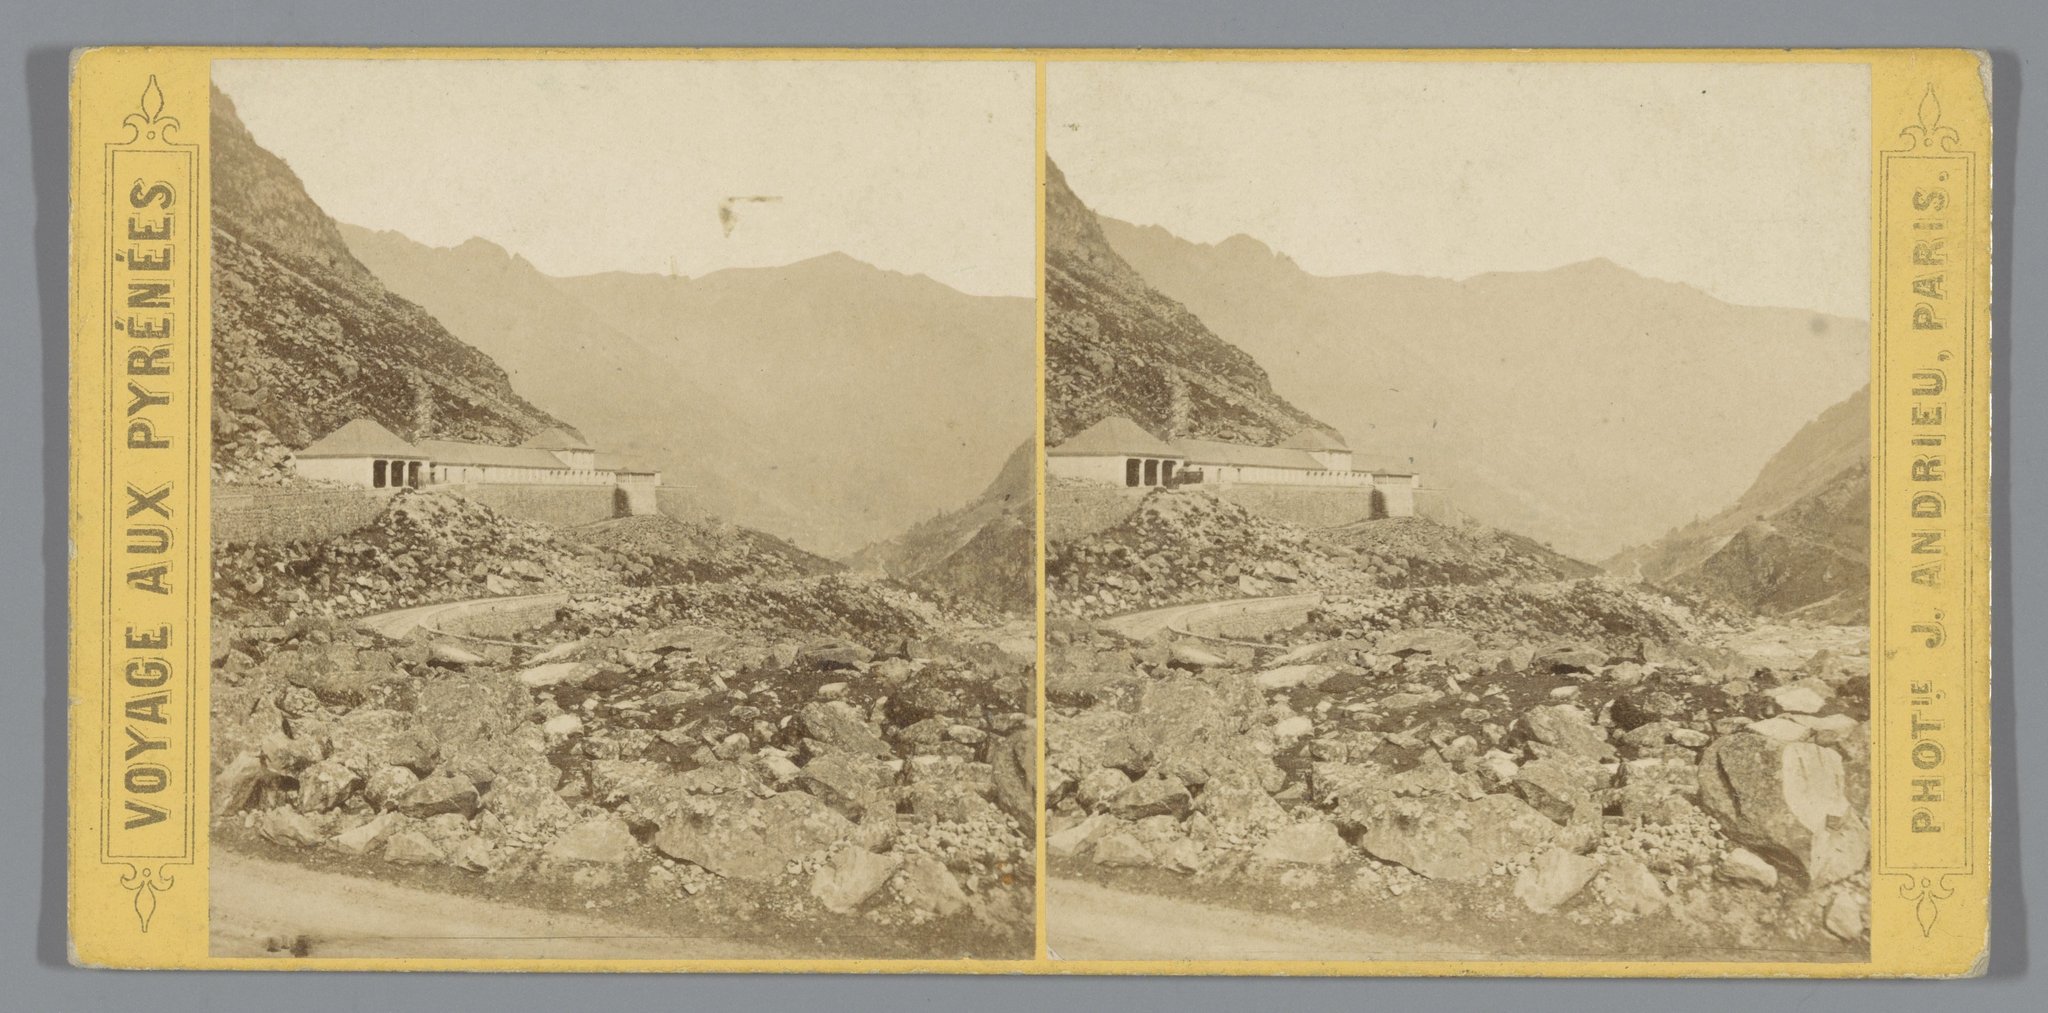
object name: stereograph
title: Gebouwen te La Raillère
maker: jean andrieu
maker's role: fotograaf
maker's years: 1816-1872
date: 1862-1876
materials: cardboard, photographic support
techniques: albumen print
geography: pyrenees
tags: housing, mountains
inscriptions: number: ‘61.’, inscription: ‘Etablissement de la Railliere a Cauterets’